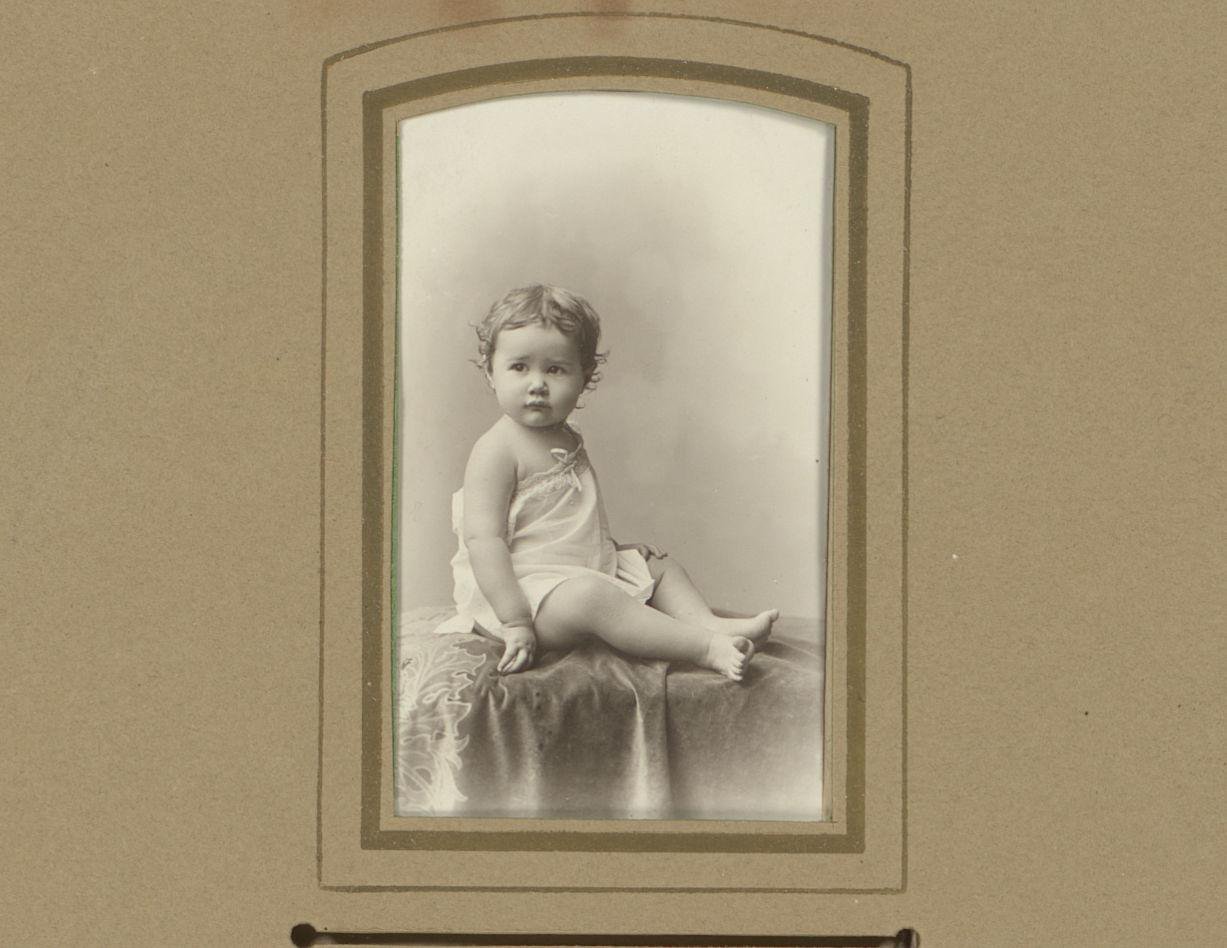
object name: photograph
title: Portret van een zittend kind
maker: Anonymous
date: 1895-1920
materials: cardboard, photographic support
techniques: matte daylight collodion silver print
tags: historical persons, tot, toddler ~ the ages of man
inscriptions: number: ‘11’